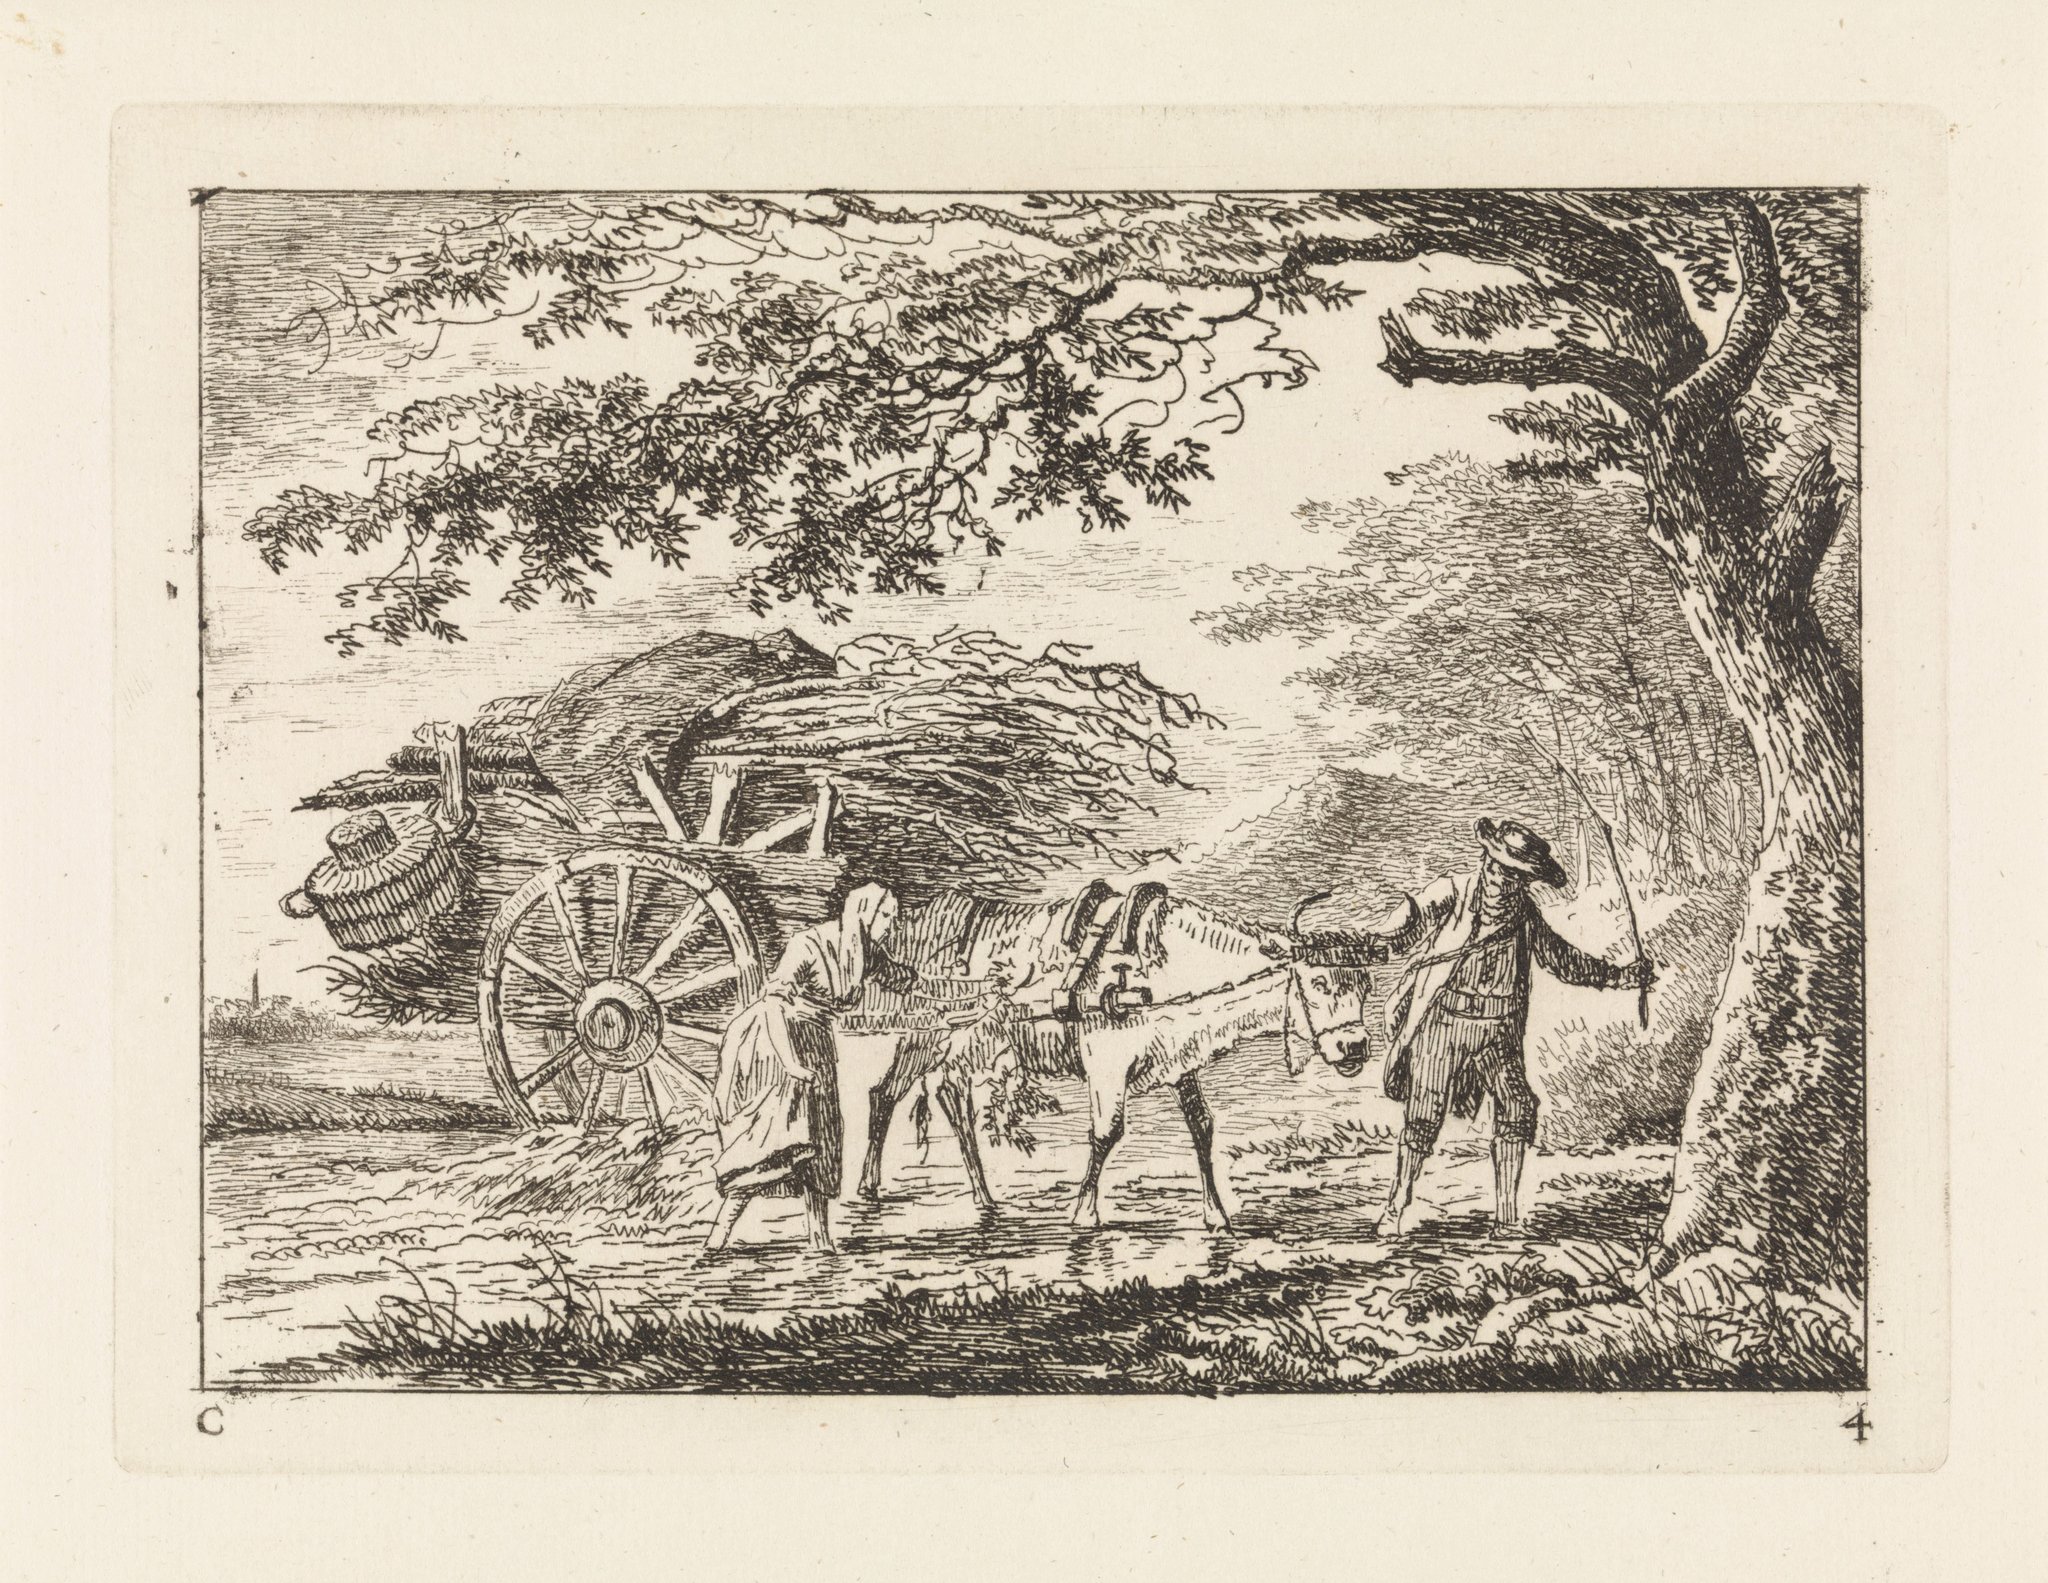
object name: print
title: Man en een vrouw bij een volgeladen ossenkar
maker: gerard van nijmegen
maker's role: draughtsman, painter, print maker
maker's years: 1735-1808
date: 1794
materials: paper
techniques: etching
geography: rotterdam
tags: ox, two-wheeled vehicle drawn by one animal, wading, paddling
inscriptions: collector's mark: Lugt 2228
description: Een man en een vrouw begeleiden een volgeladen ossenkar en waden daarmee door ondiep water. Linksonder: c.